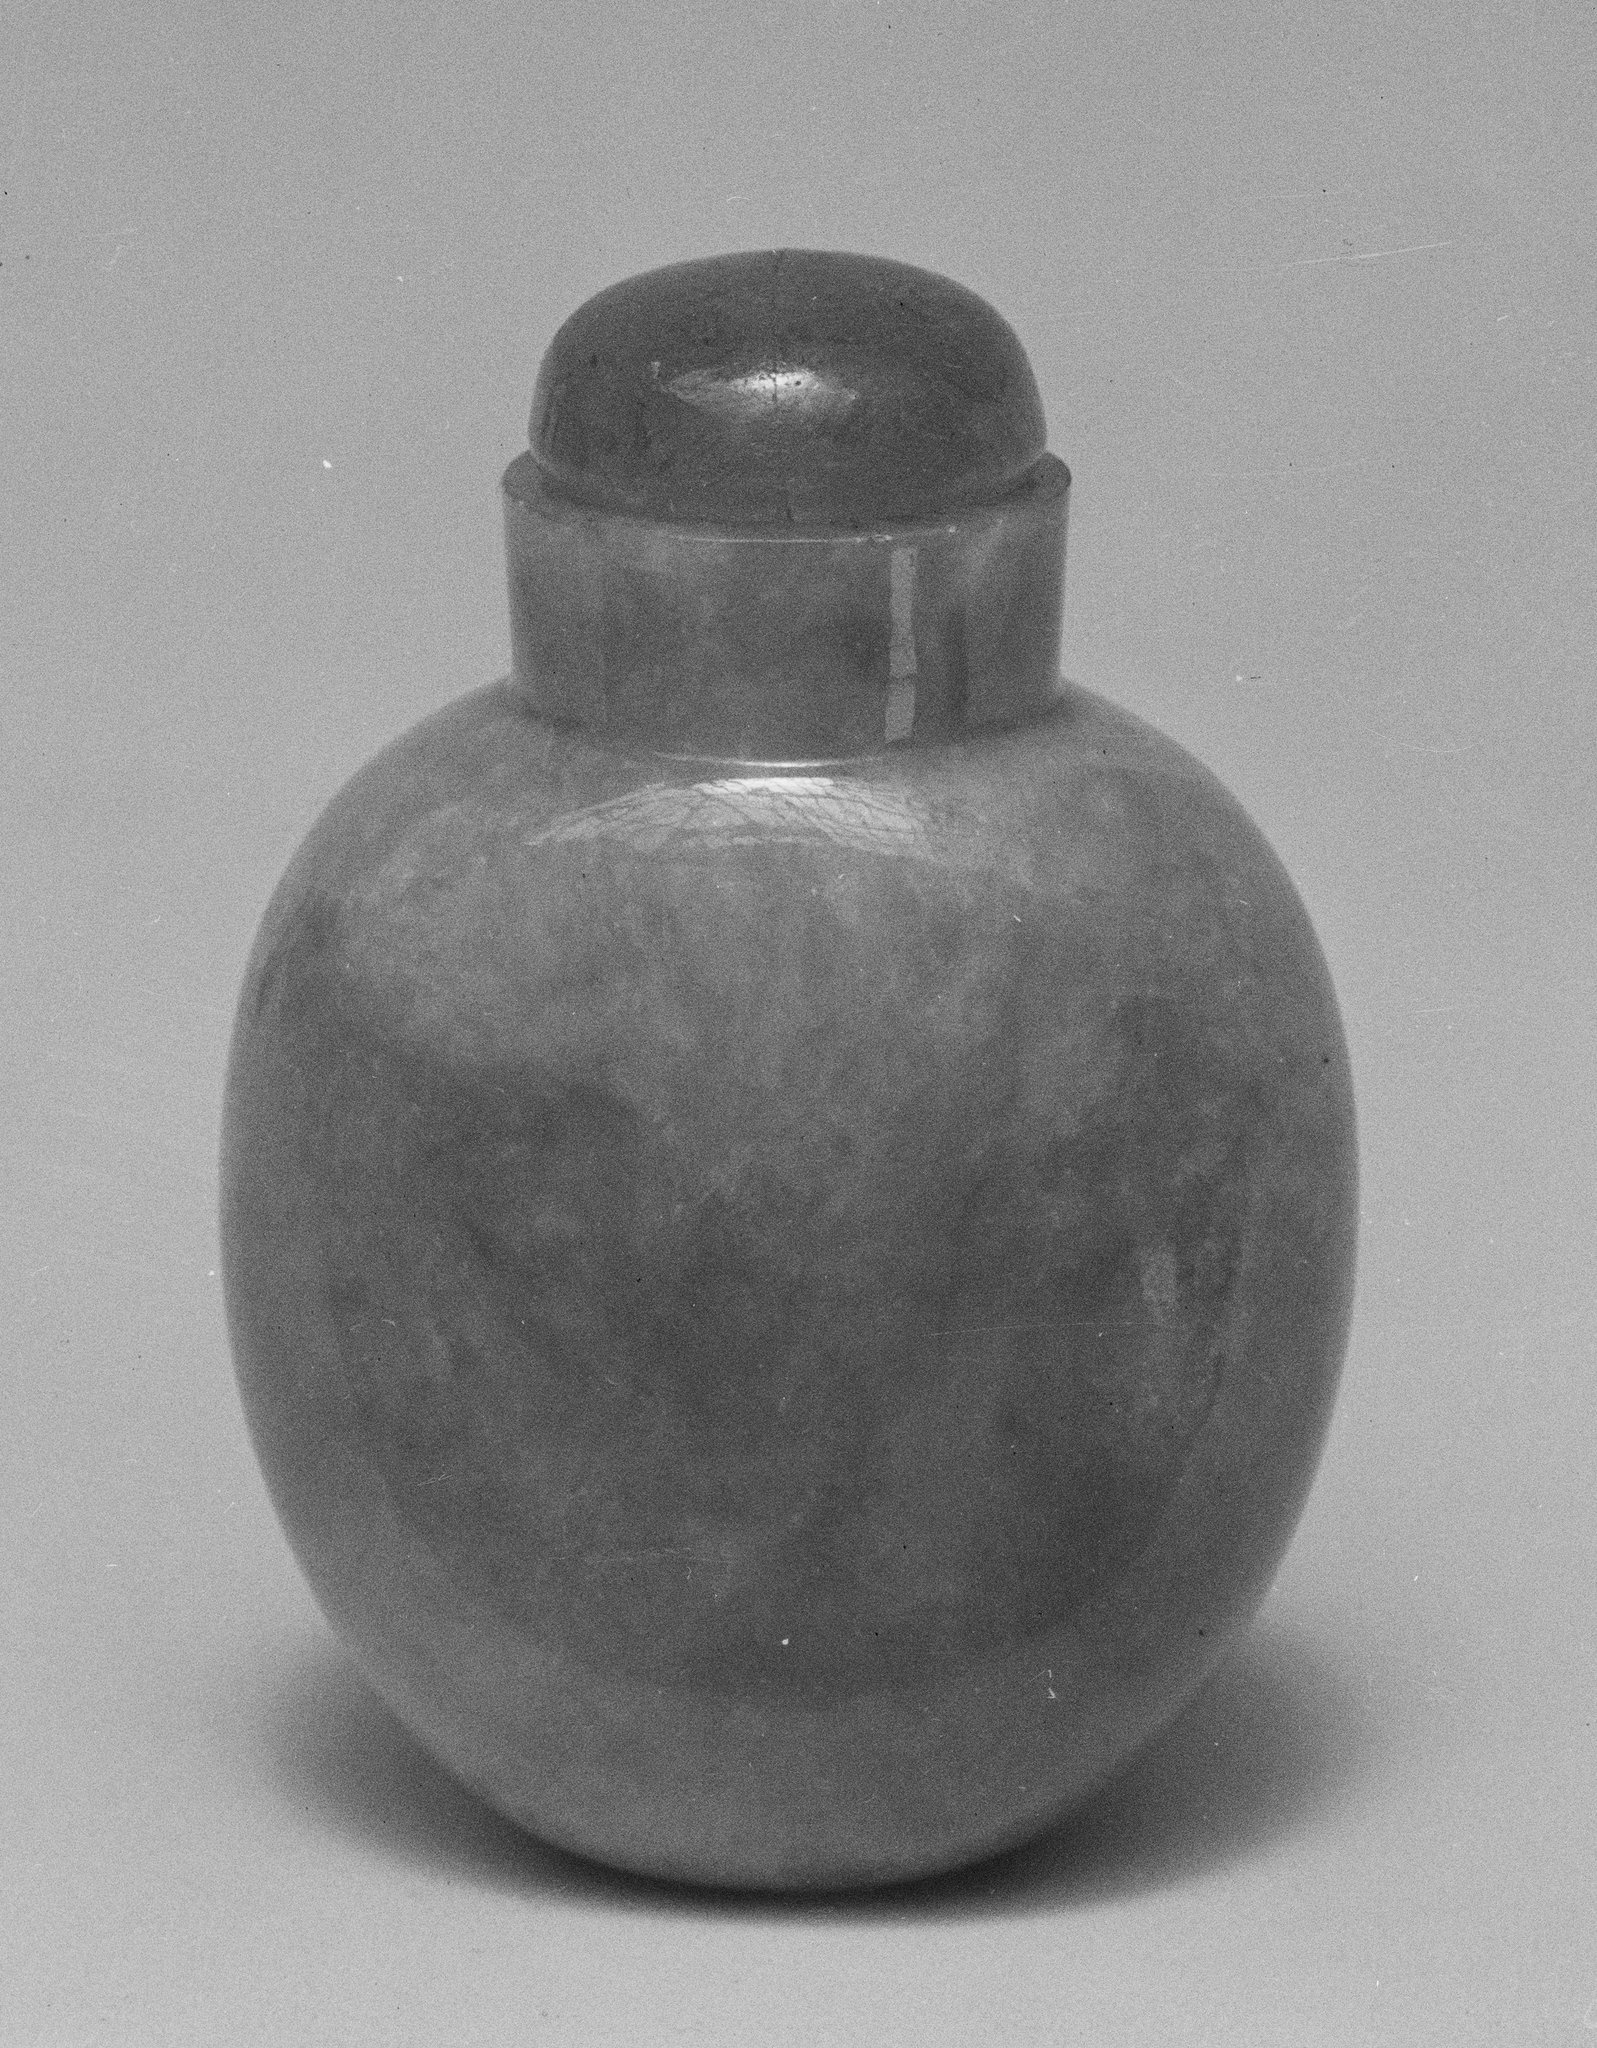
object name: snuff bottle with stopper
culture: chinese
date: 1736-1795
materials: jade, gemstone